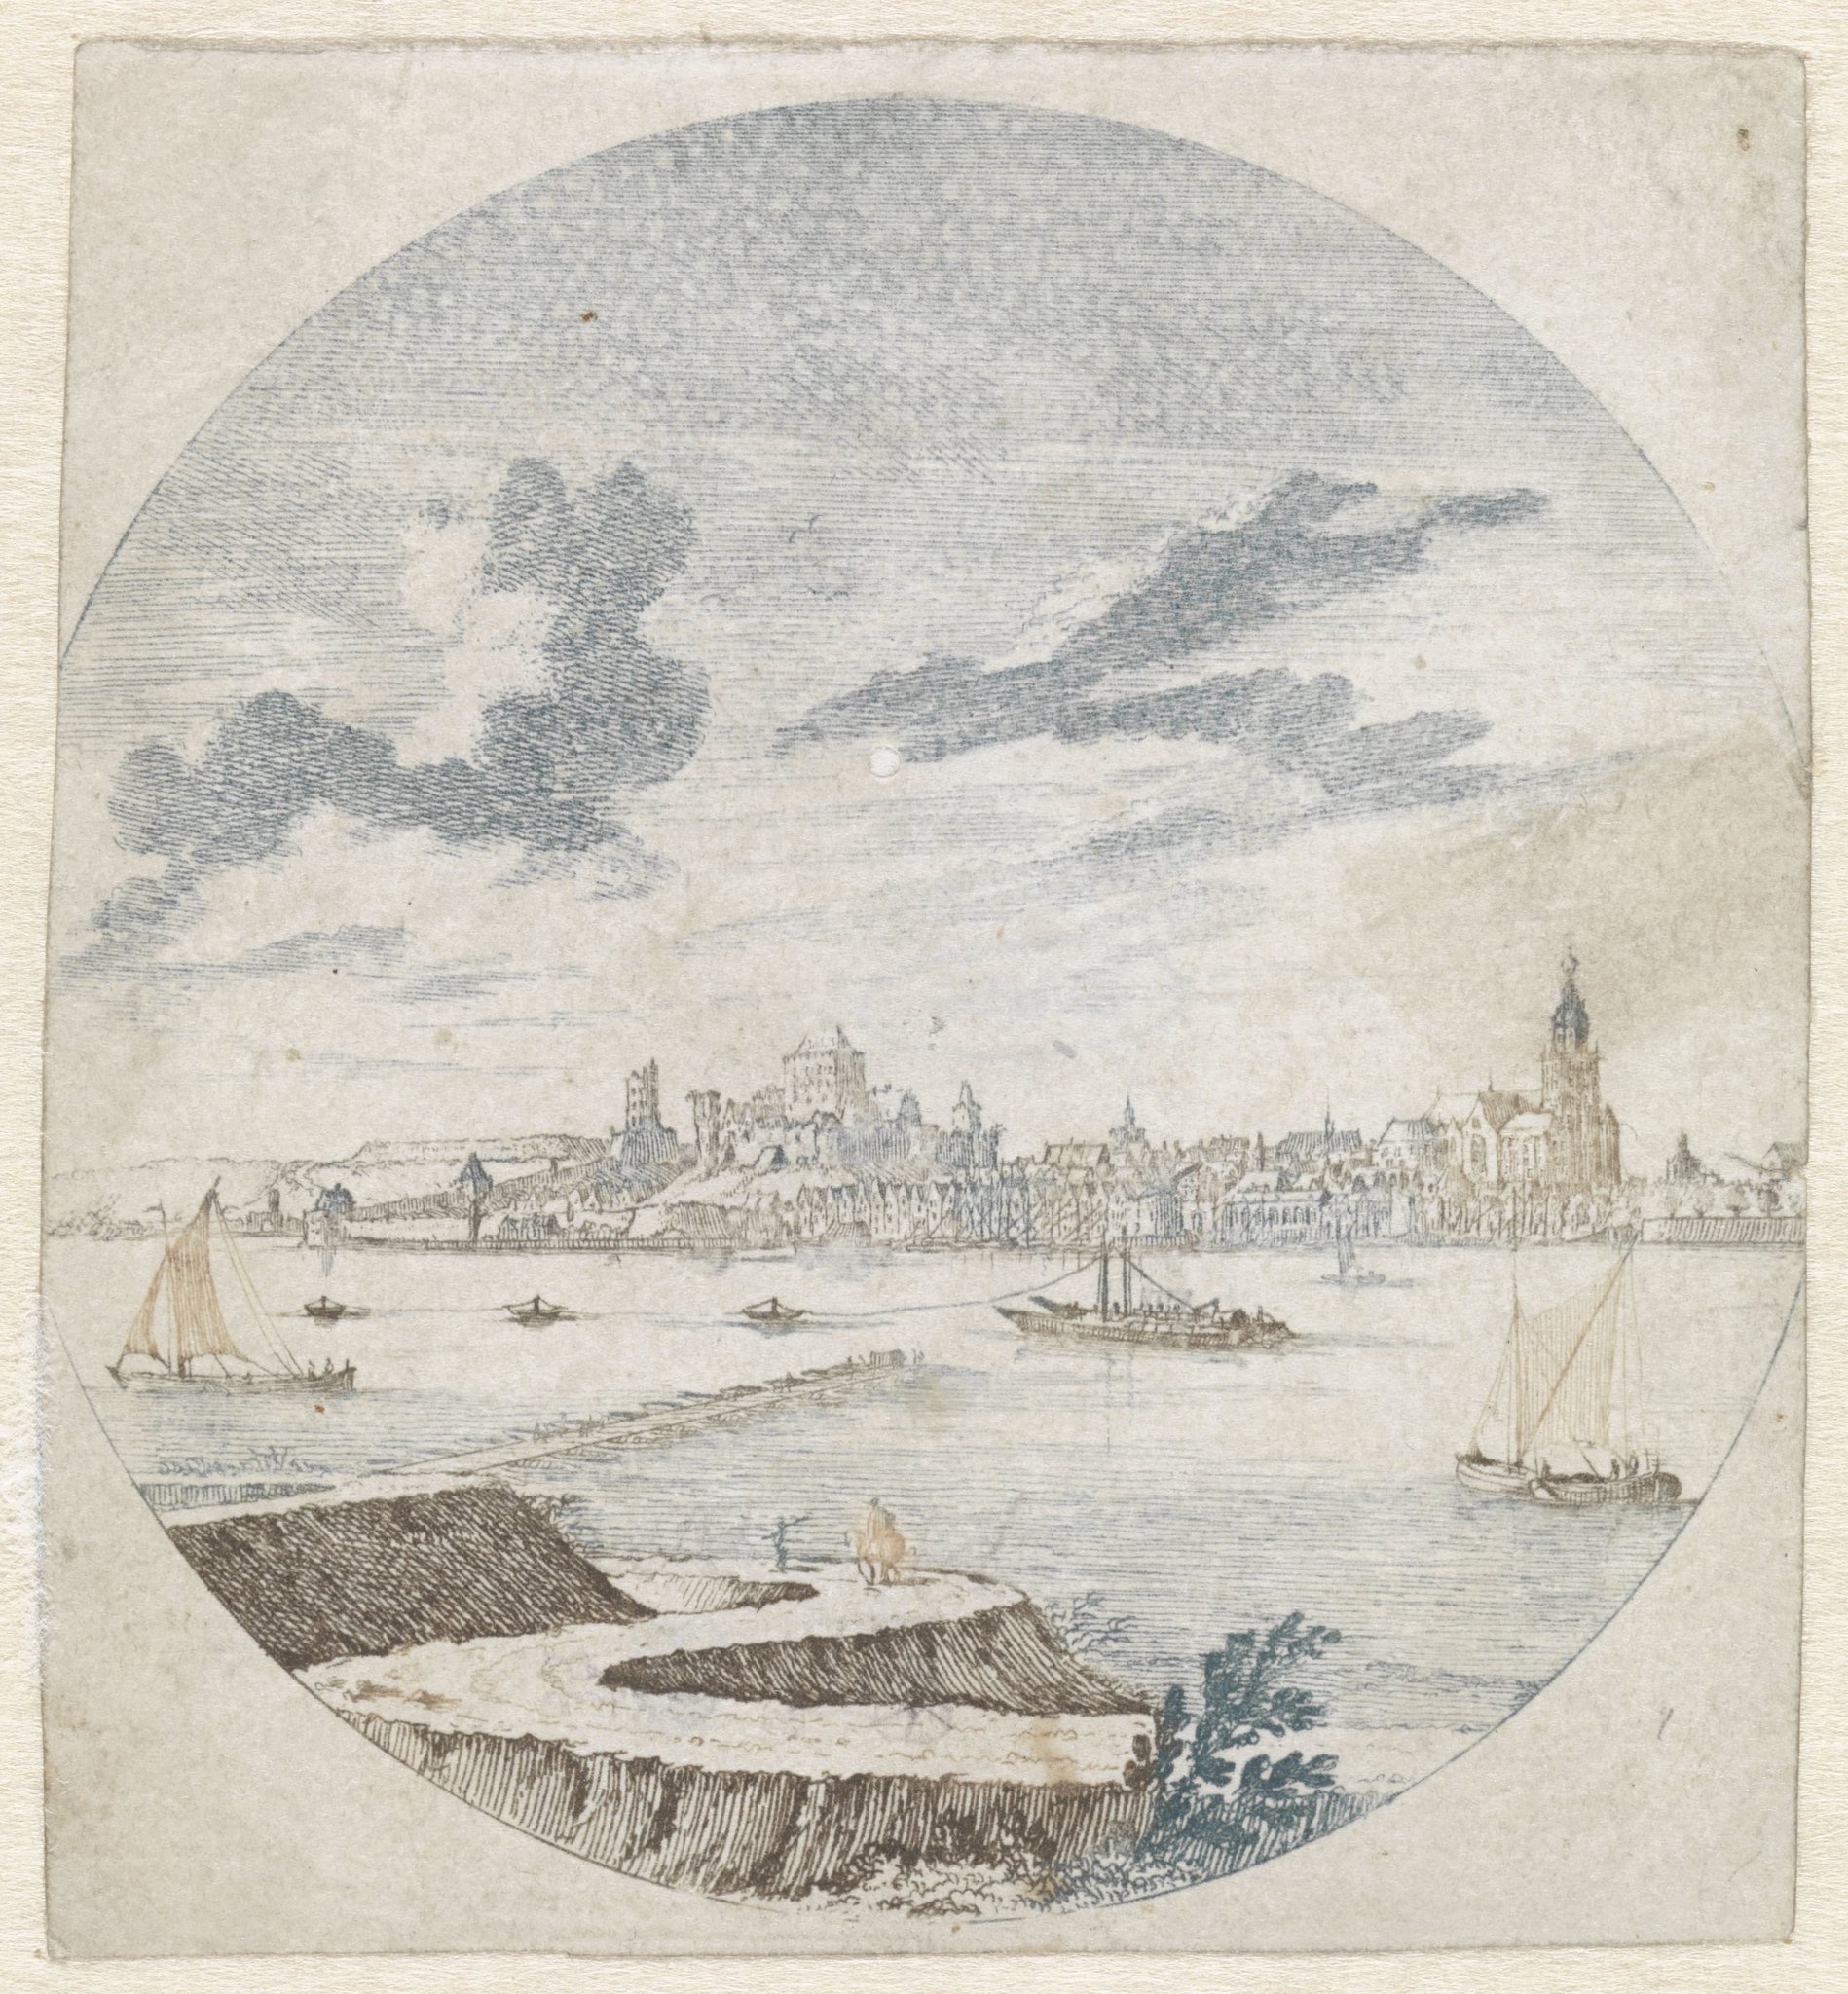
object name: print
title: Gezicht op Nijmegen vanuit het noorden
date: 1688-1698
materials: paper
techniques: etching, lithography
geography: netherlands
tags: river, nijmegen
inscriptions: collector's mark: Lugt 2760, collector's mark: Lugt 2228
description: Gezicht op de stad Nijmegen vanuit het noorden. Op de voorgrond de rivier met zeilschepen.